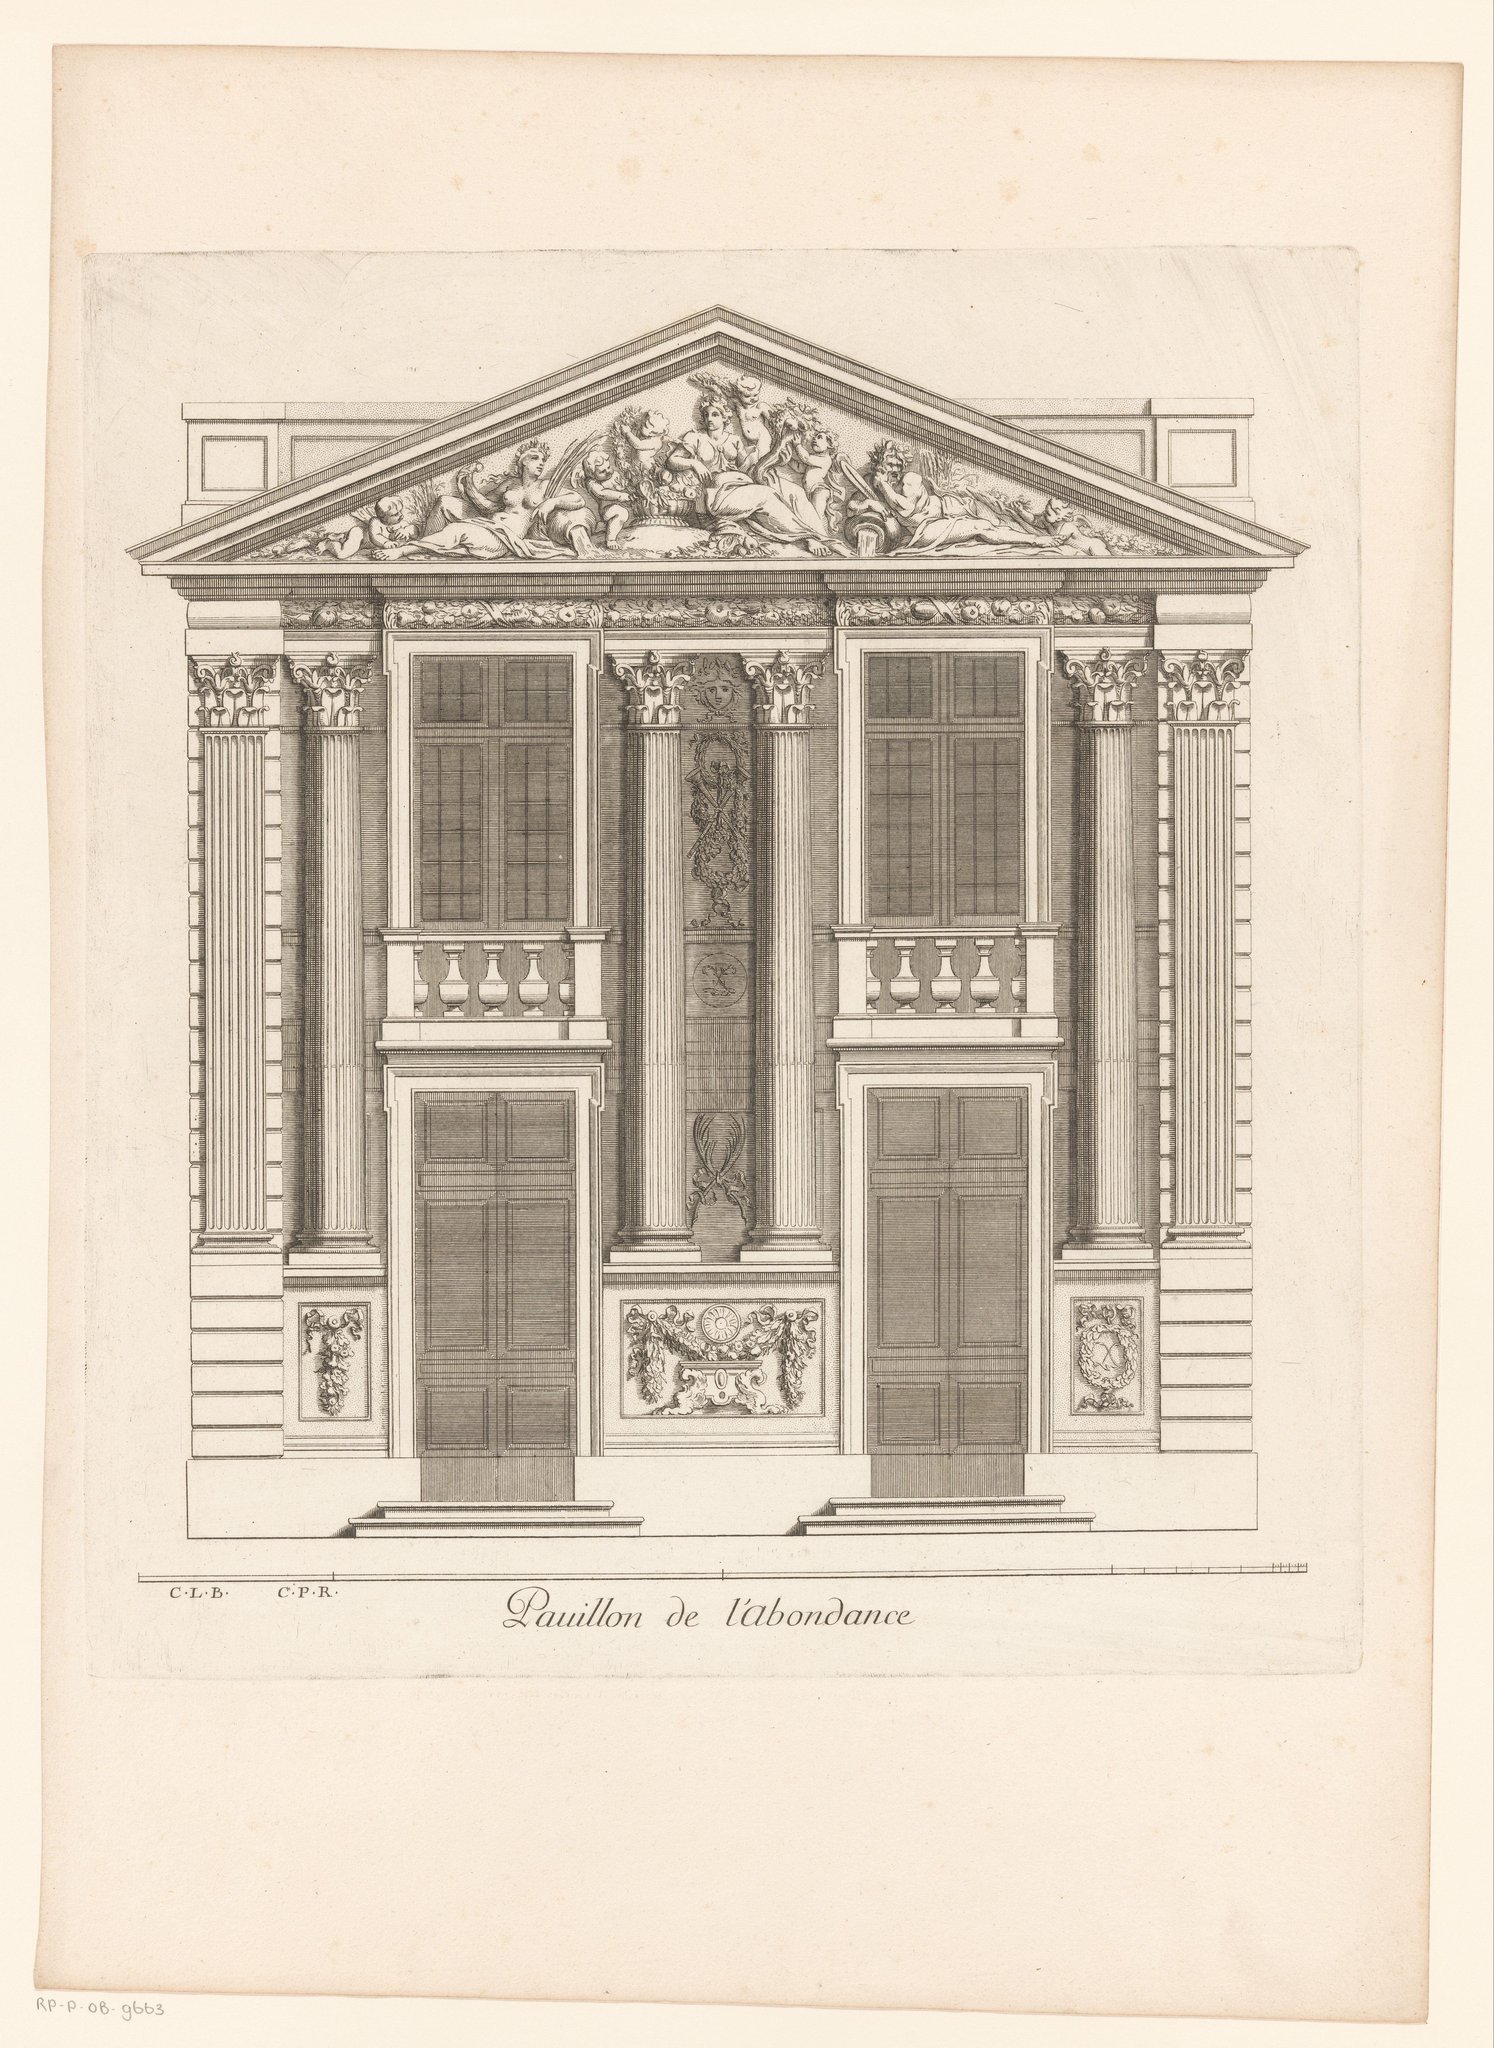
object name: print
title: Paviljoen van Abundantia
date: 1672-1686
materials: paper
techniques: etching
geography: paris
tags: façade (of house or building), abundantia (abundance) as roman personification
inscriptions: collector's mark: Lugt 2228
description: Façade van een paviljoen met Korinthische zuilen en pilasters, tabletten met guirlandes, balkons en een driehoekig fronton met Abundantia omgeven door putti en riviergoden.